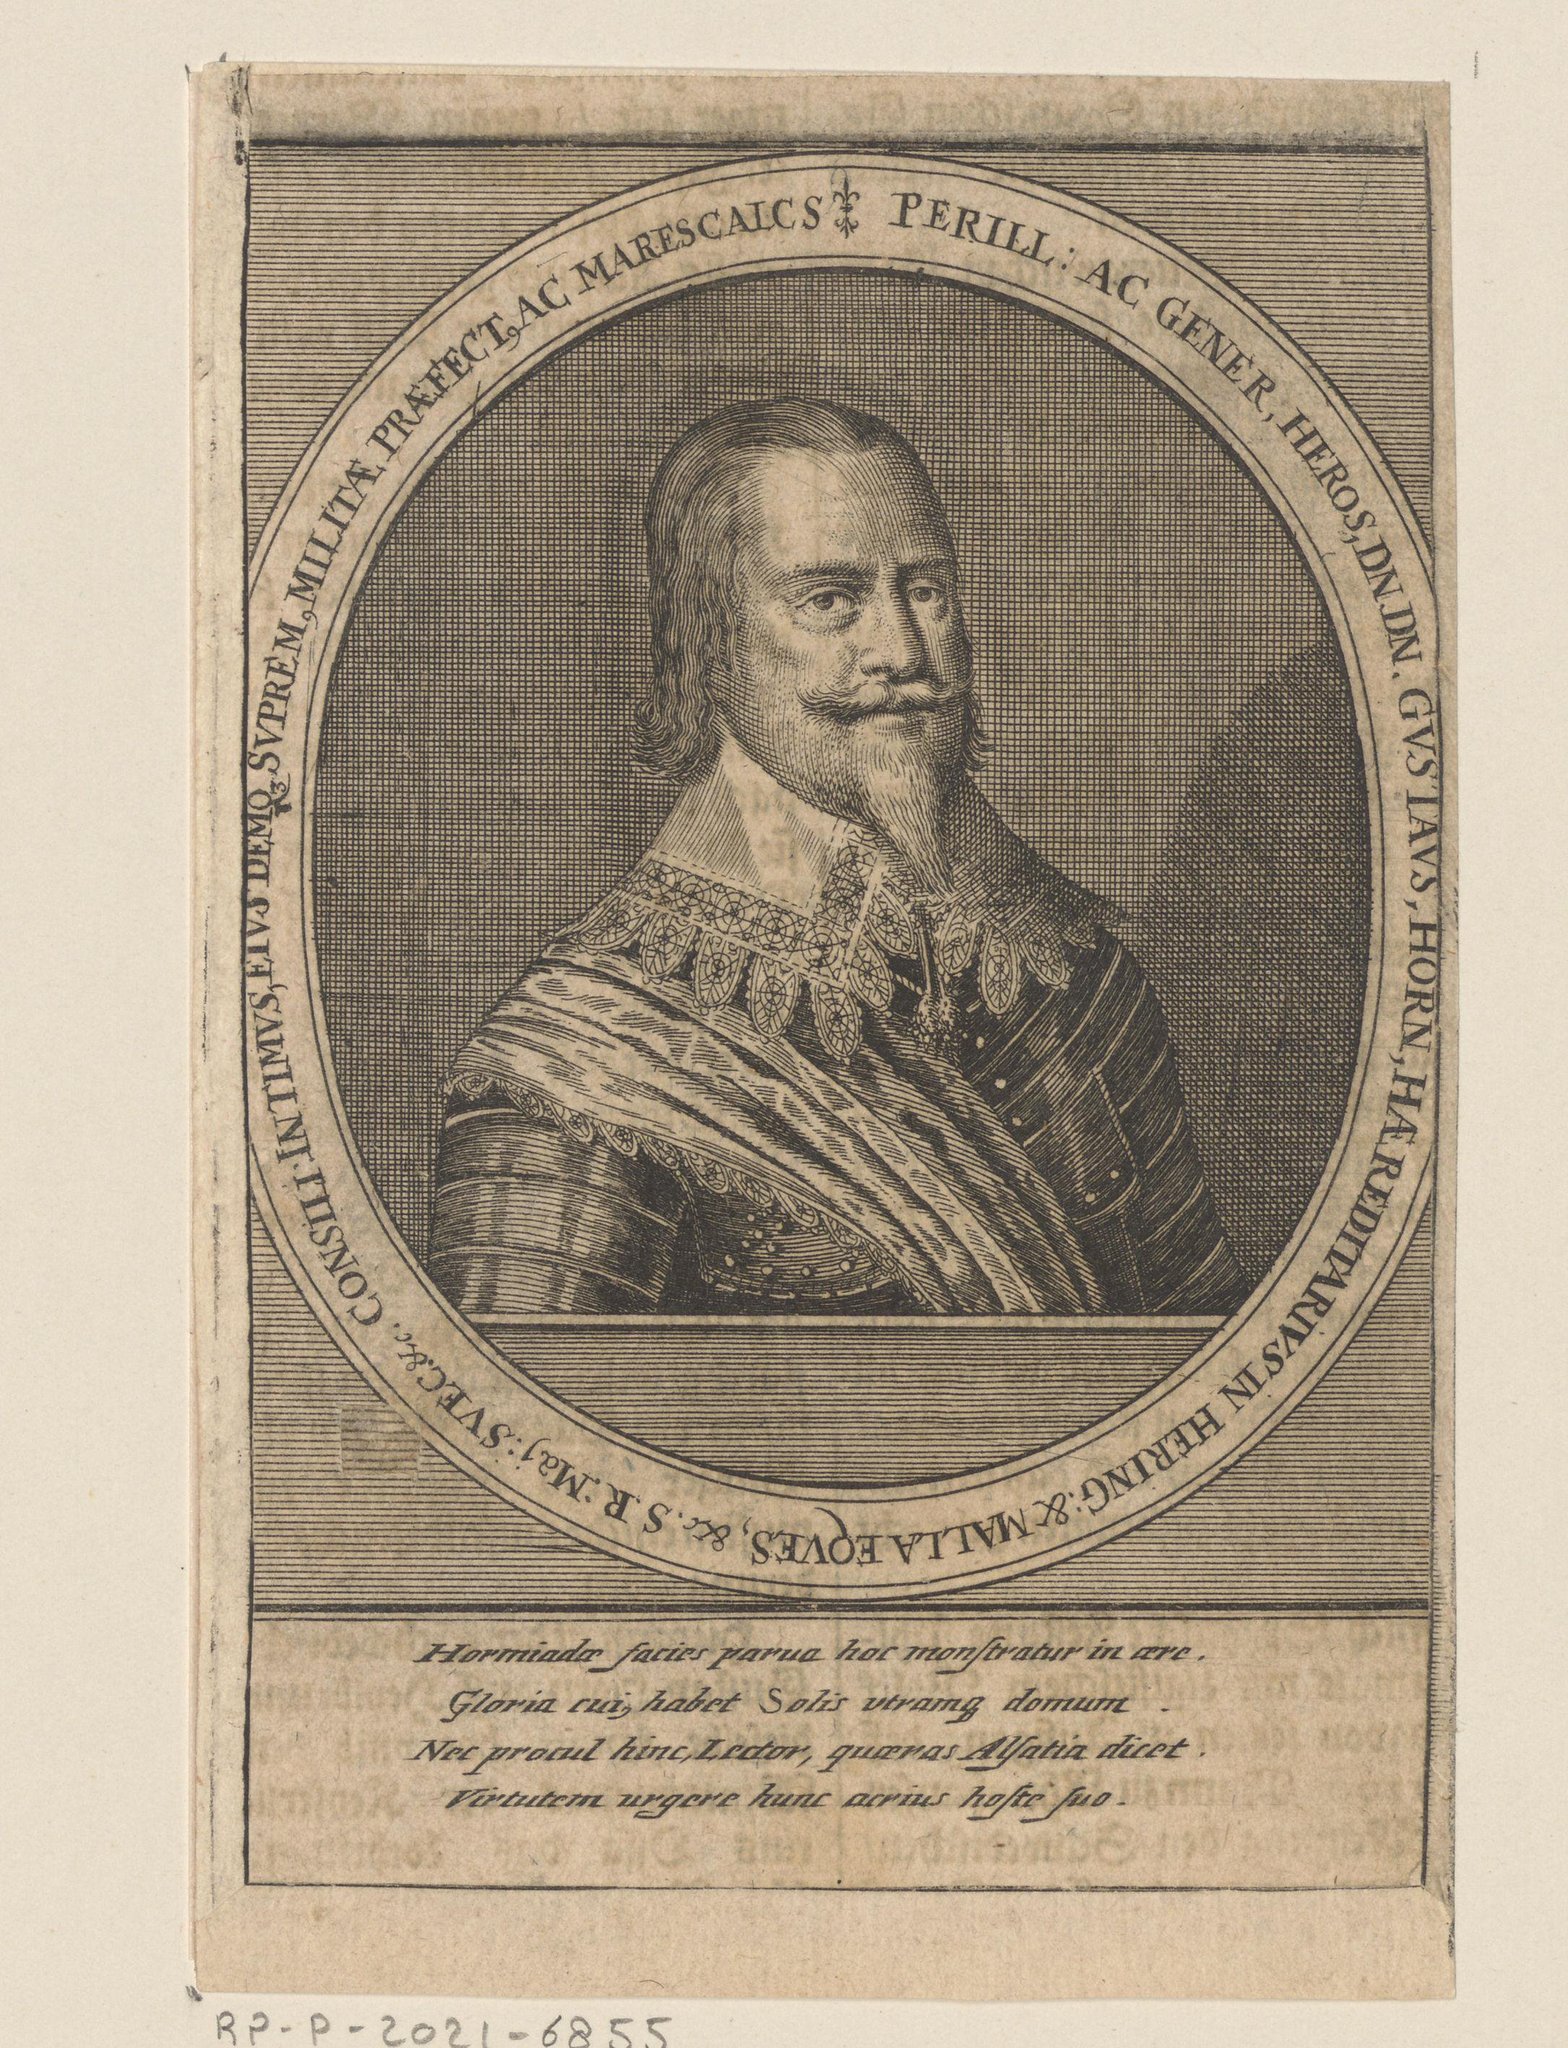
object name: book illustration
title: Portret van Gustav Horn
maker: Anonymous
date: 1650-1699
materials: paper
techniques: engraving, etching, letterpress printing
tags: commander-in-chief, general, marshal, historical persons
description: Prent mogelijk uit: Theatrum Europaeum, 1635-1738.